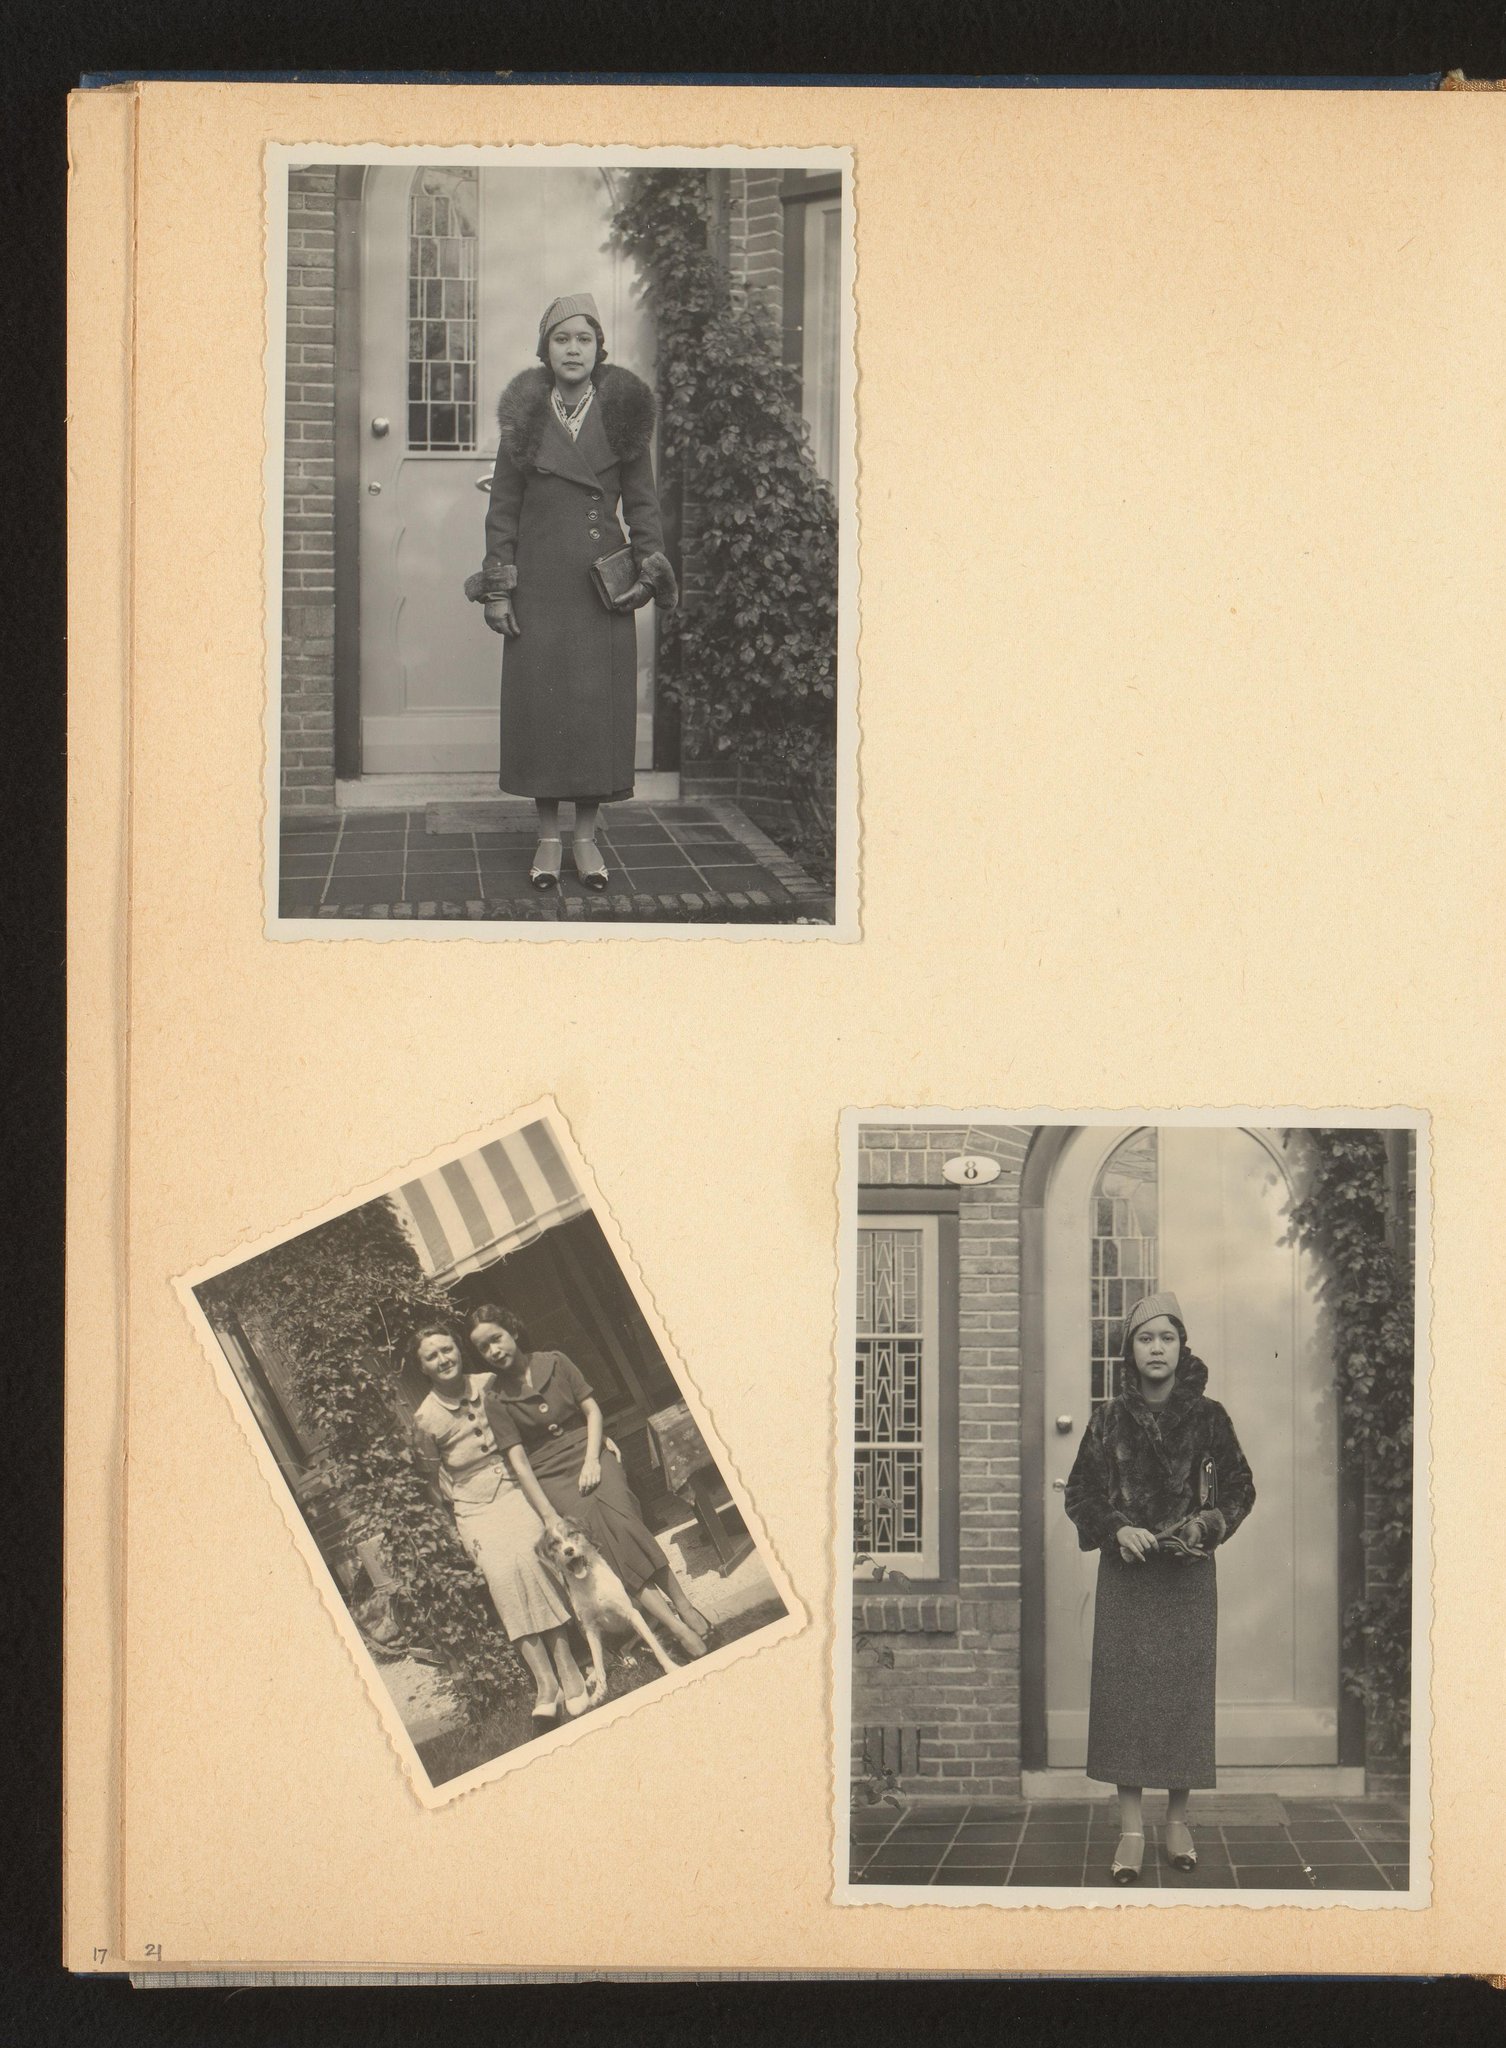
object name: photograph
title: Eef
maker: frédéric gabriël dumas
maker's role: engineer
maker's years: 1886-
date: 1935-1940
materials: cardboard, photographic support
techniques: gelatin silver print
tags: surabaya, paris, beatrice jacqueline eveline dumas, adolescent, young woman, maiden, historical persons - bb - woman, netherlands, dutch east indies, the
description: Blad met drie foto's van Eef als jonge vrouw, in Nederland. Onderdeel van het fotoalbum van Beatrice Jacqueline Eveline (Eef) Dumas, ca. 1880-1952.